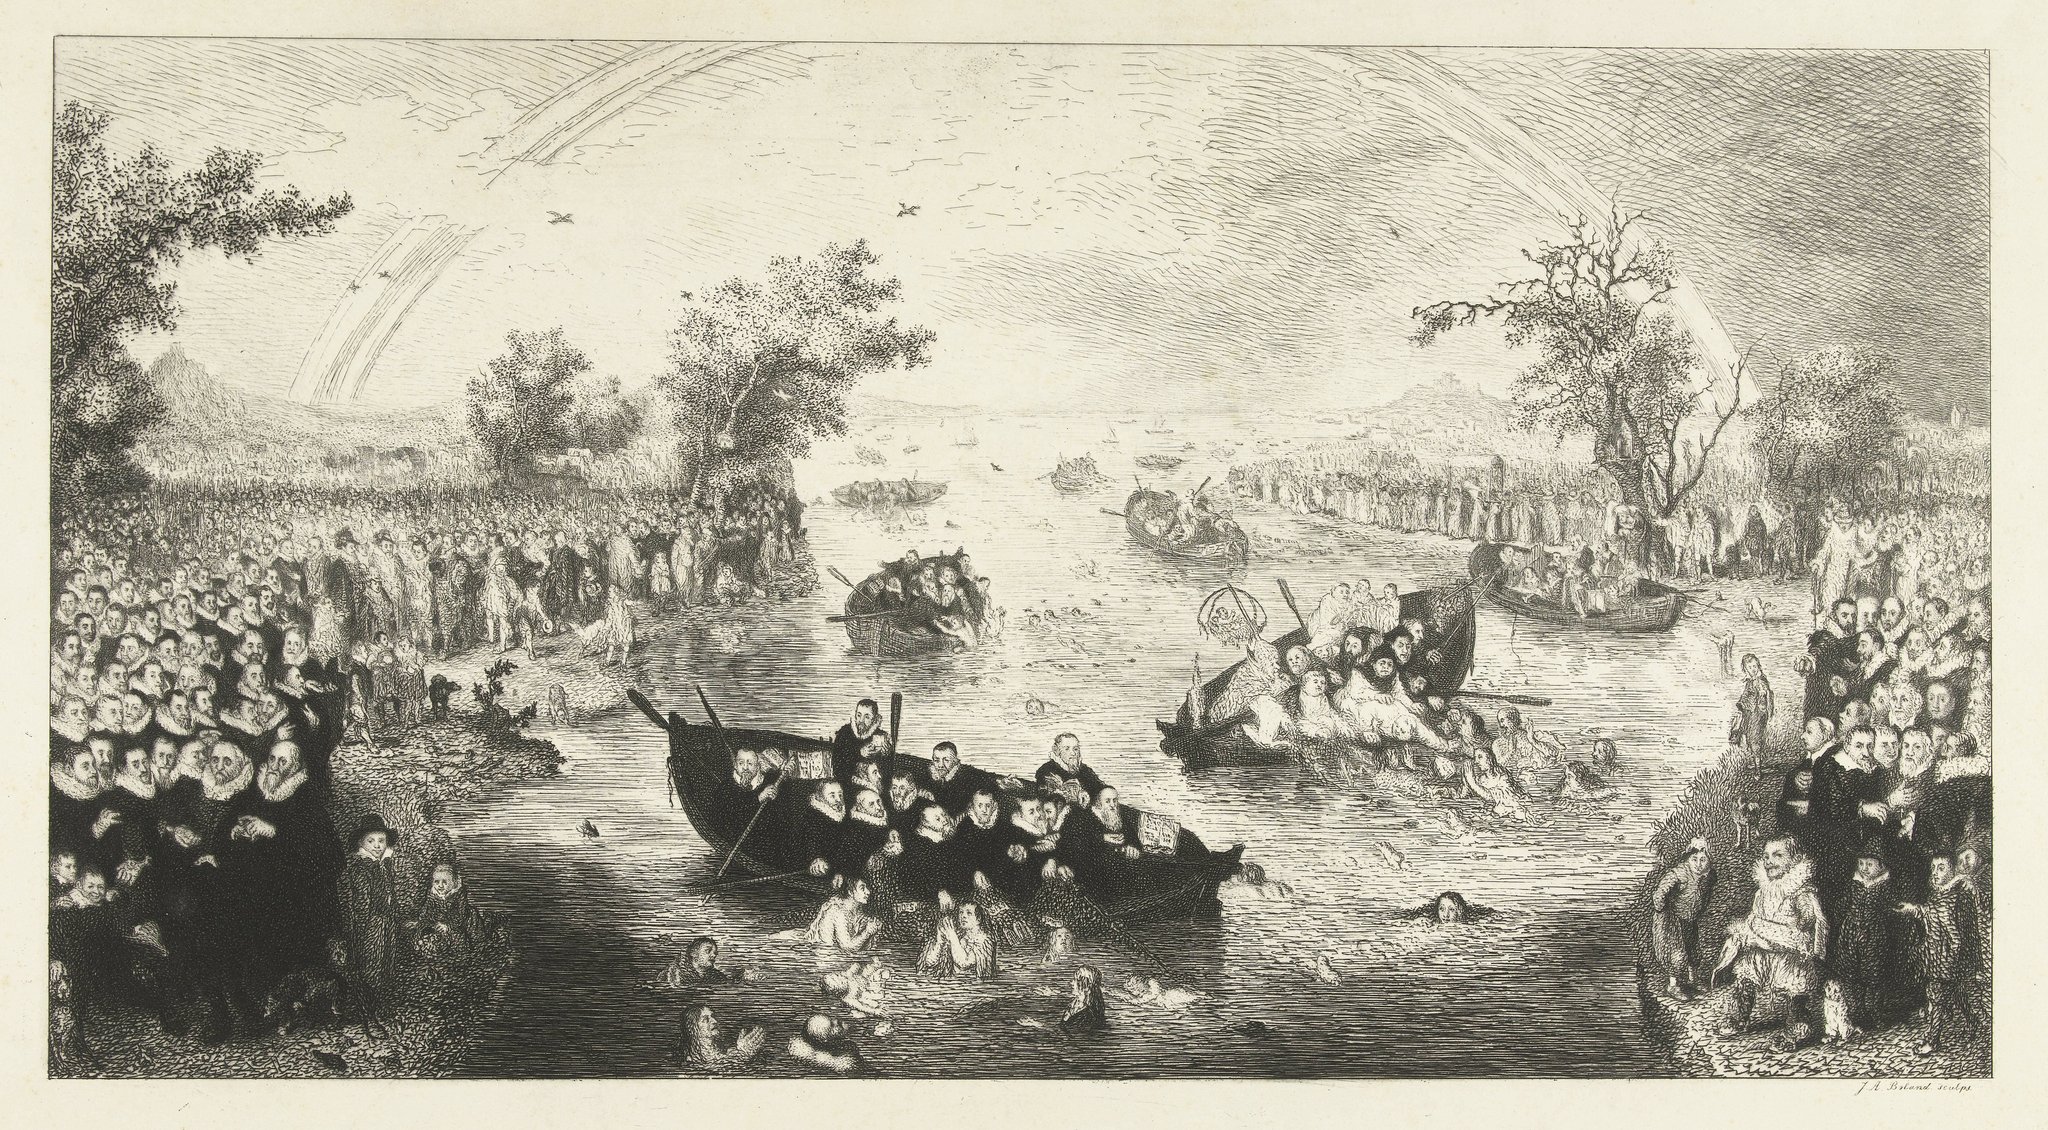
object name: print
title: De zielenvisserij: allegorie op de ijverzucht van de verschillende religies tijdens het Twaalfjarig Bestand tussen de Nederlandse Republiek en Spanje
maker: johannes arnoldus boland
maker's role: print maker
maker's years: 1838-1922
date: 1860-1900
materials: paper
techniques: etching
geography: amsterdam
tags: netherlands, spain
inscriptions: collector's mark: Lugt 2228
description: Reproductie van een schilderij uit de collectie van het Rijksmuseum Amsterdam, SK-A-447.